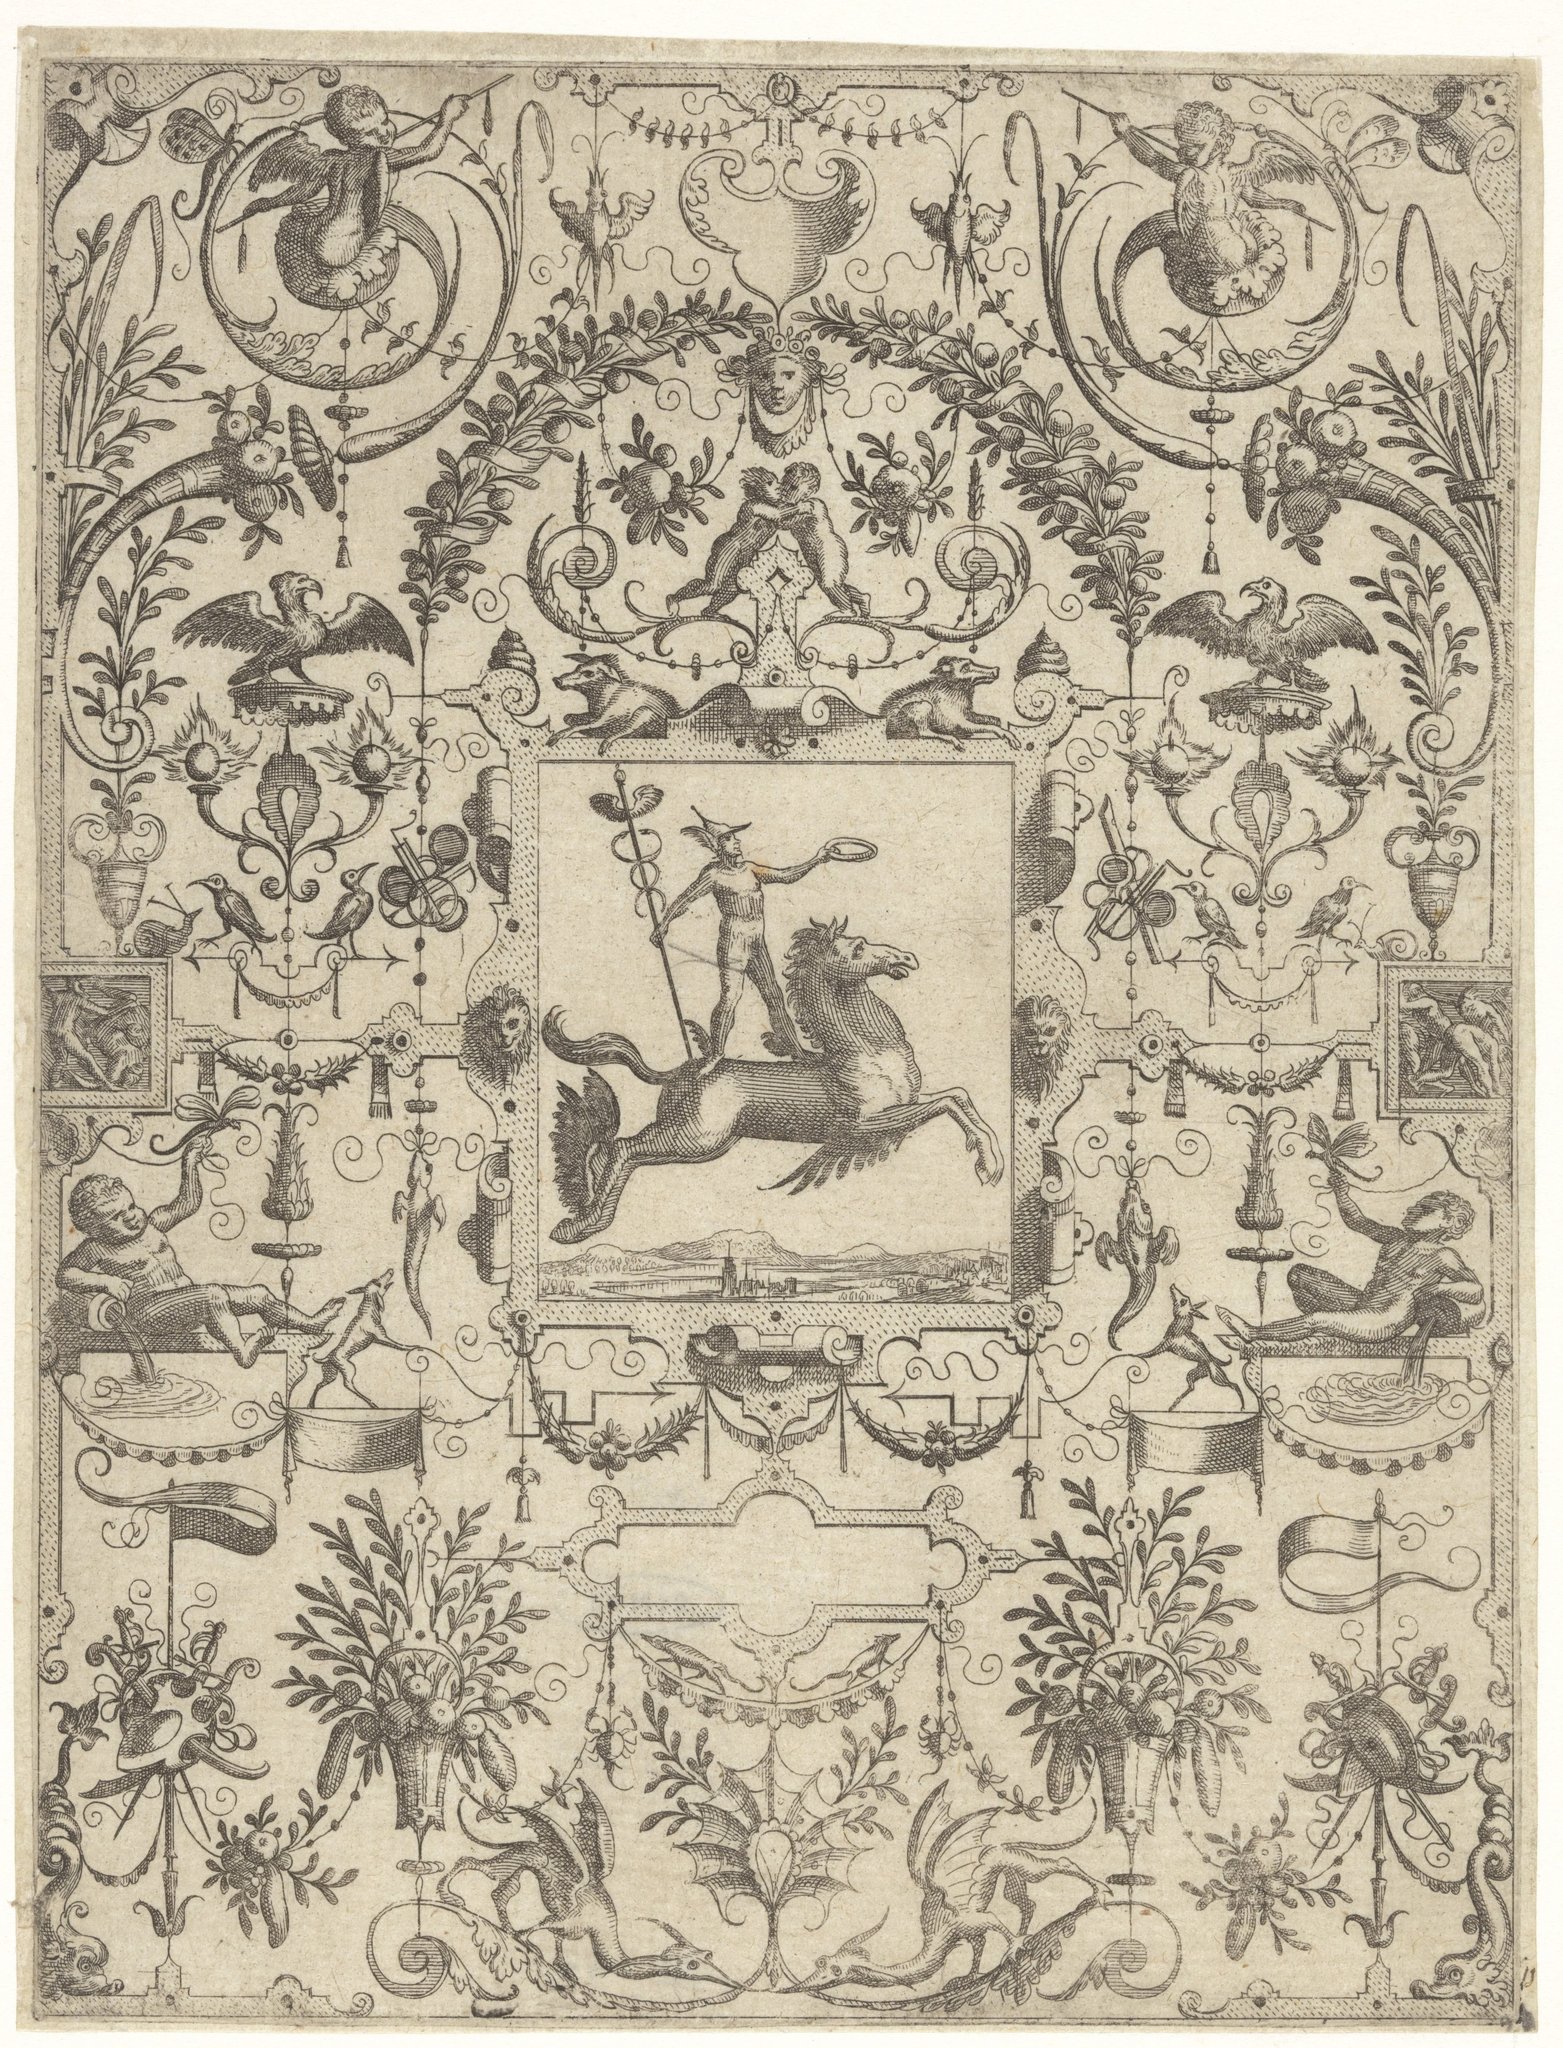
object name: ornament print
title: Grottesco: in diversche manieren…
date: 1565-1571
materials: paper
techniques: etching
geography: netherlands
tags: pegasus, the winged horse, (story of) mercury (hermes), ornament ~ cartouche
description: Op de bladranken boven de cartouche staan twee elkaar omhelzende kinderen, elk met een zwijn onder zijn voeten. Uit serie van titelblad + 16 bladen met cartouches of architectuurfantasieën met een voorstelling in een omlijsting van grotesken met fabelwezens, dieren, guirlandes, trofeeën en mascarons.